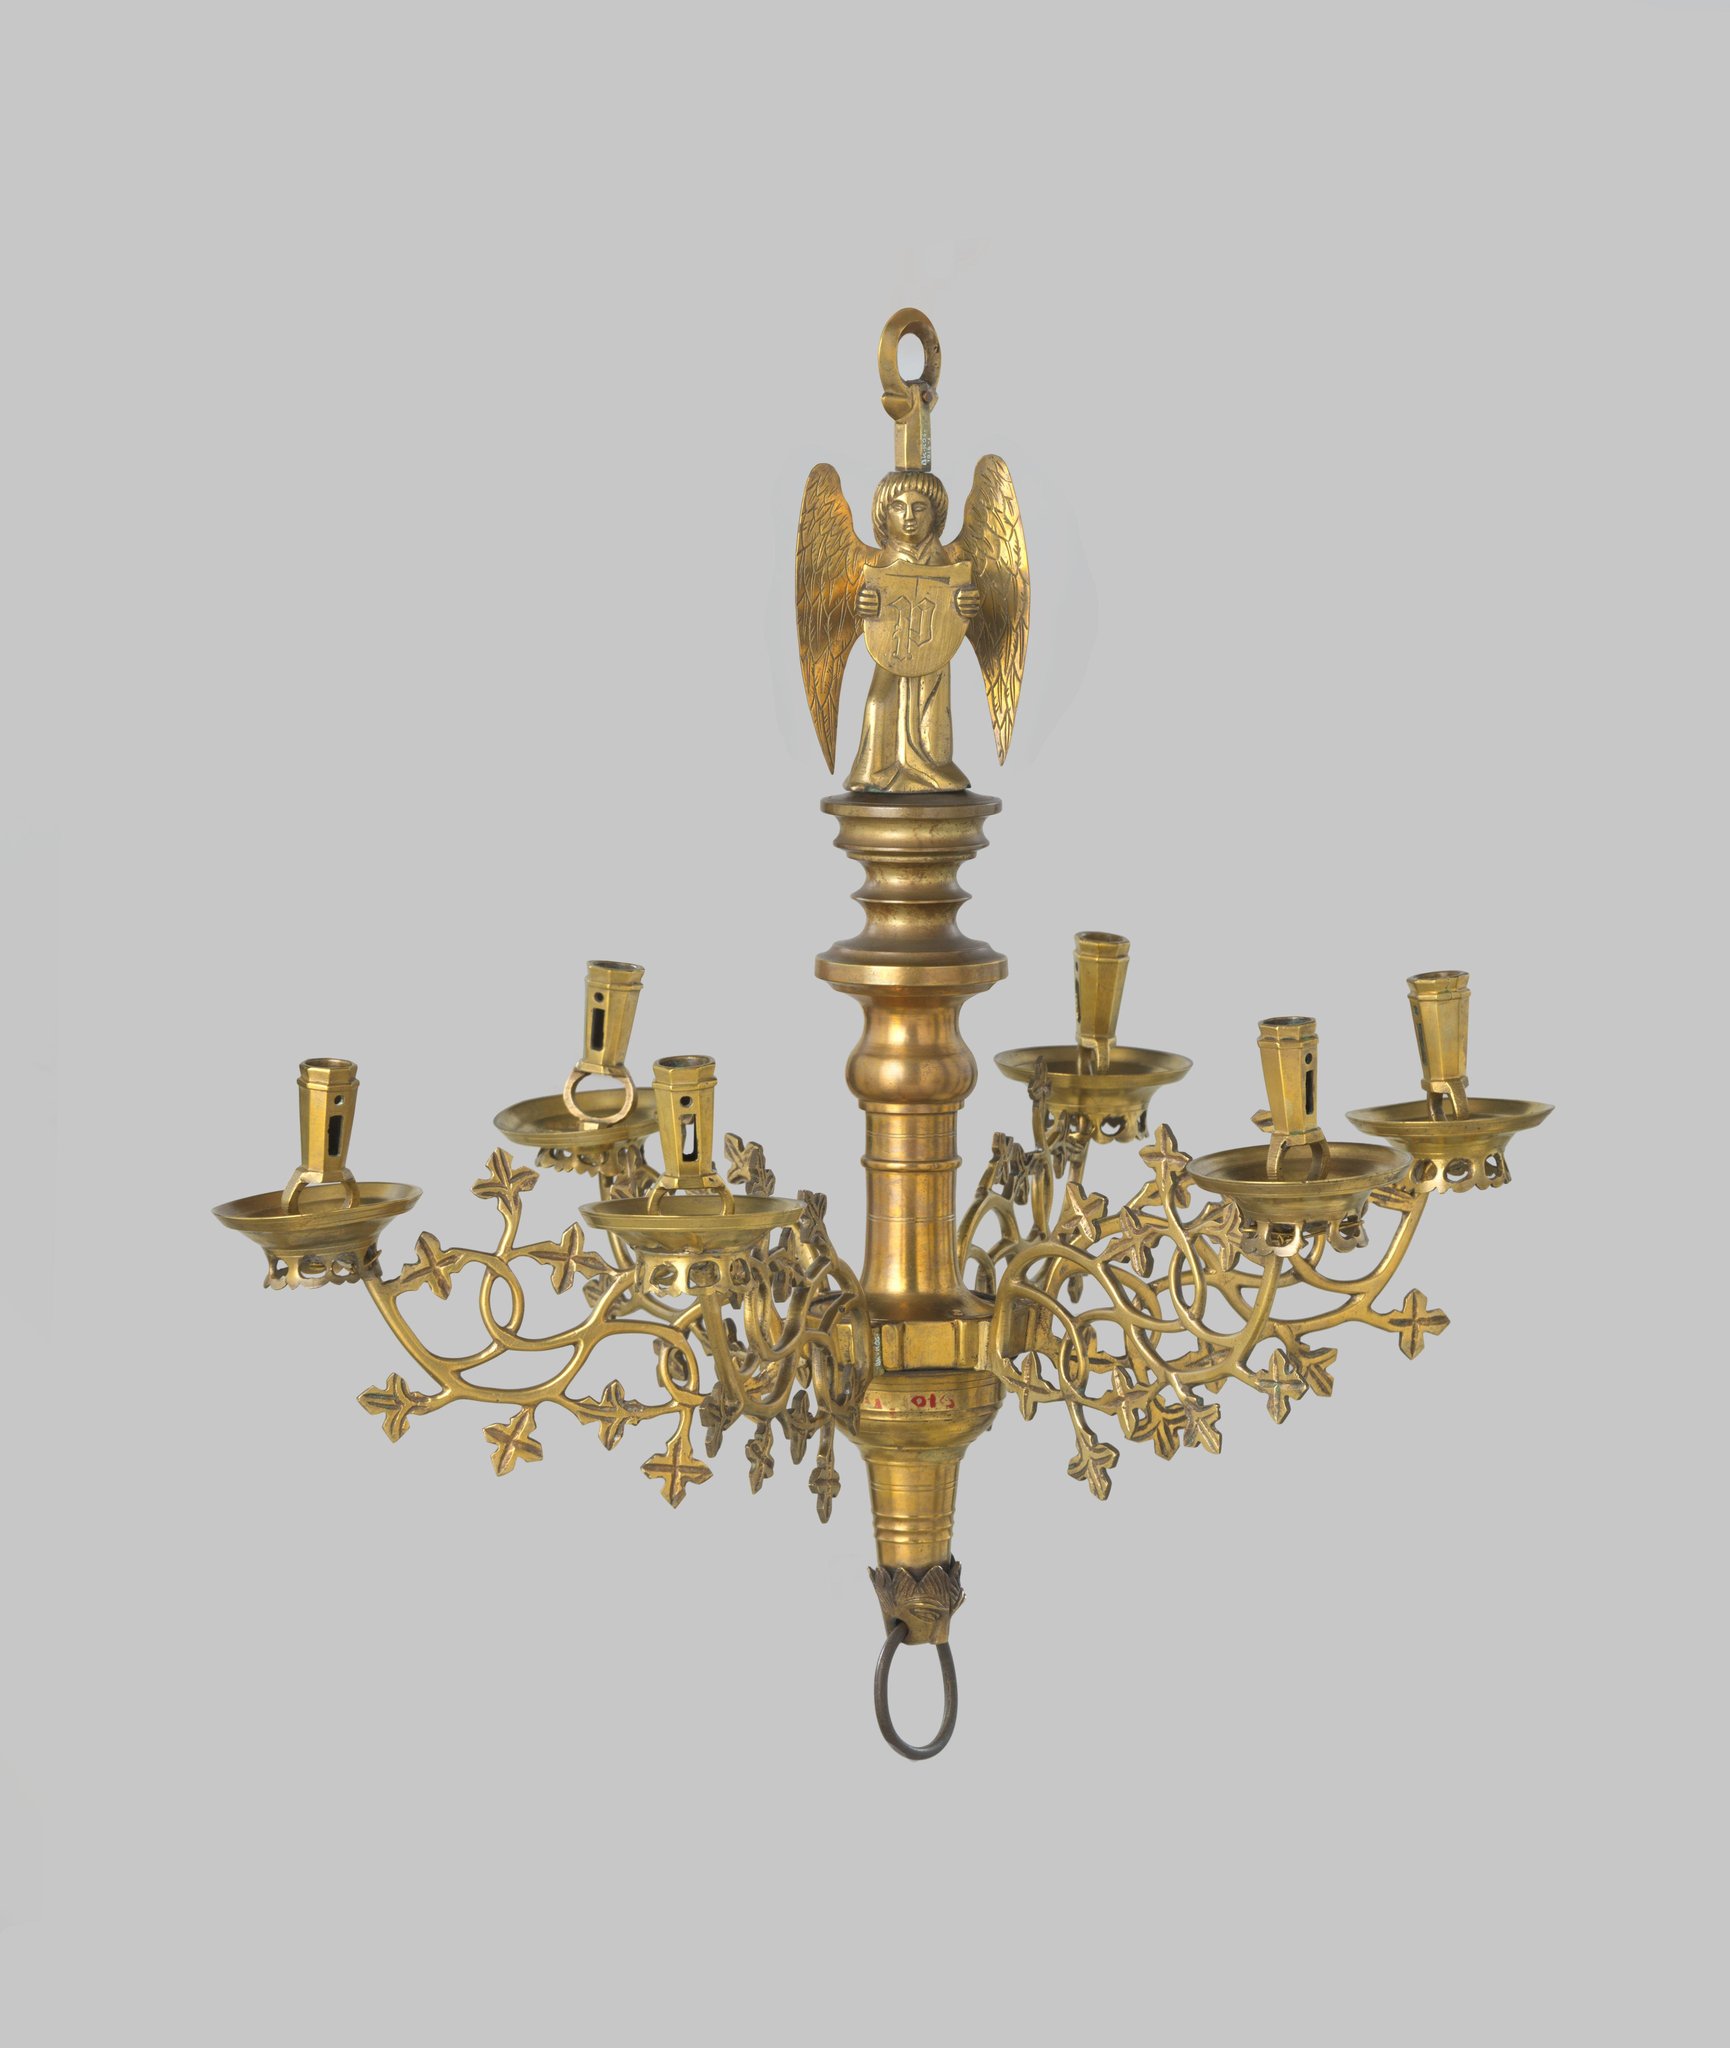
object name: chandelier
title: Arm met kaarsenhouder van kaarsenkroon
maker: Anonymous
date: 1825-1875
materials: brass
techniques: casting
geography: western europe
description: Kaarsenarm behorende bij een messing kaarsenkroon. De S-vormige arm is versierd met negen wingerdbladeren wingerdbladeren, ten dele aan verstrengelde ranken, en eindigt in de platte verdikking met een schroefgat. De ronde vetvanger is voorzien van ajour bewerkte gekartelde versieringen aan de onderzijde. Deze is bevestigd met een achtvlakkige voor en achter geperforeerde kaarsenhouder op verticale ringvormige voet, die op de armen zijn geschroefd. Dit is de vijfde arm, genummerd met 5 driehoeken.